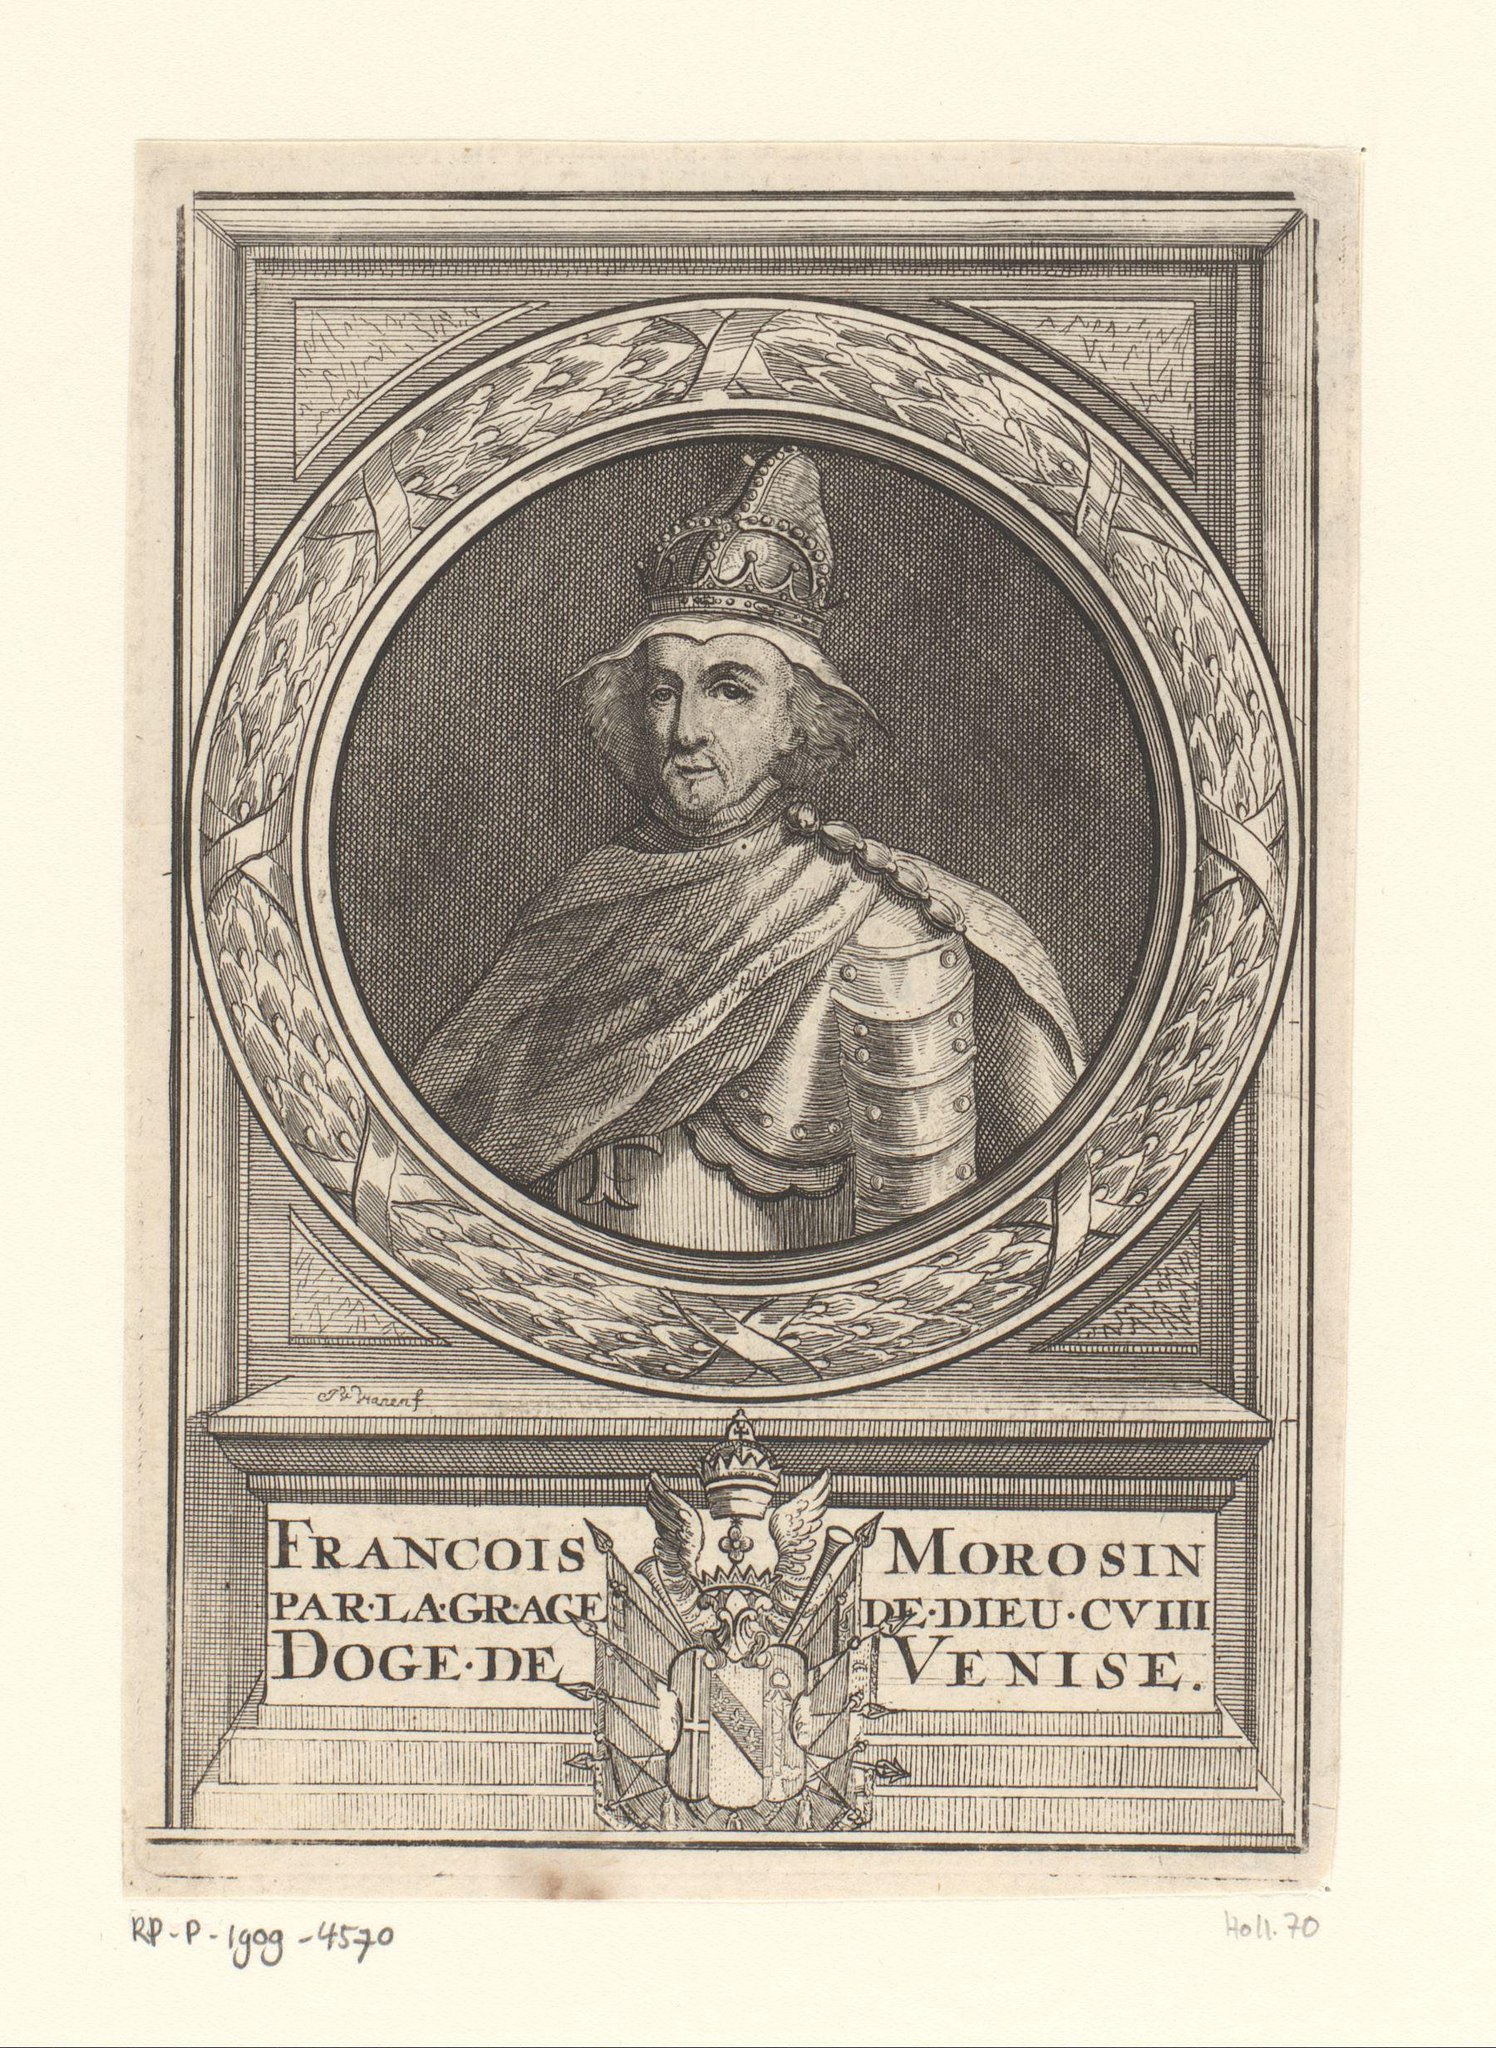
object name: print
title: Portret van Francesco Morosini, Doge te Venetië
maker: jan van vianen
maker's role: print maker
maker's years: 1660-1726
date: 1670-1736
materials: paper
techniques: etching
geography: northern netherlands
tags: venice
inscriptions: collector's mark: Lugt 2228